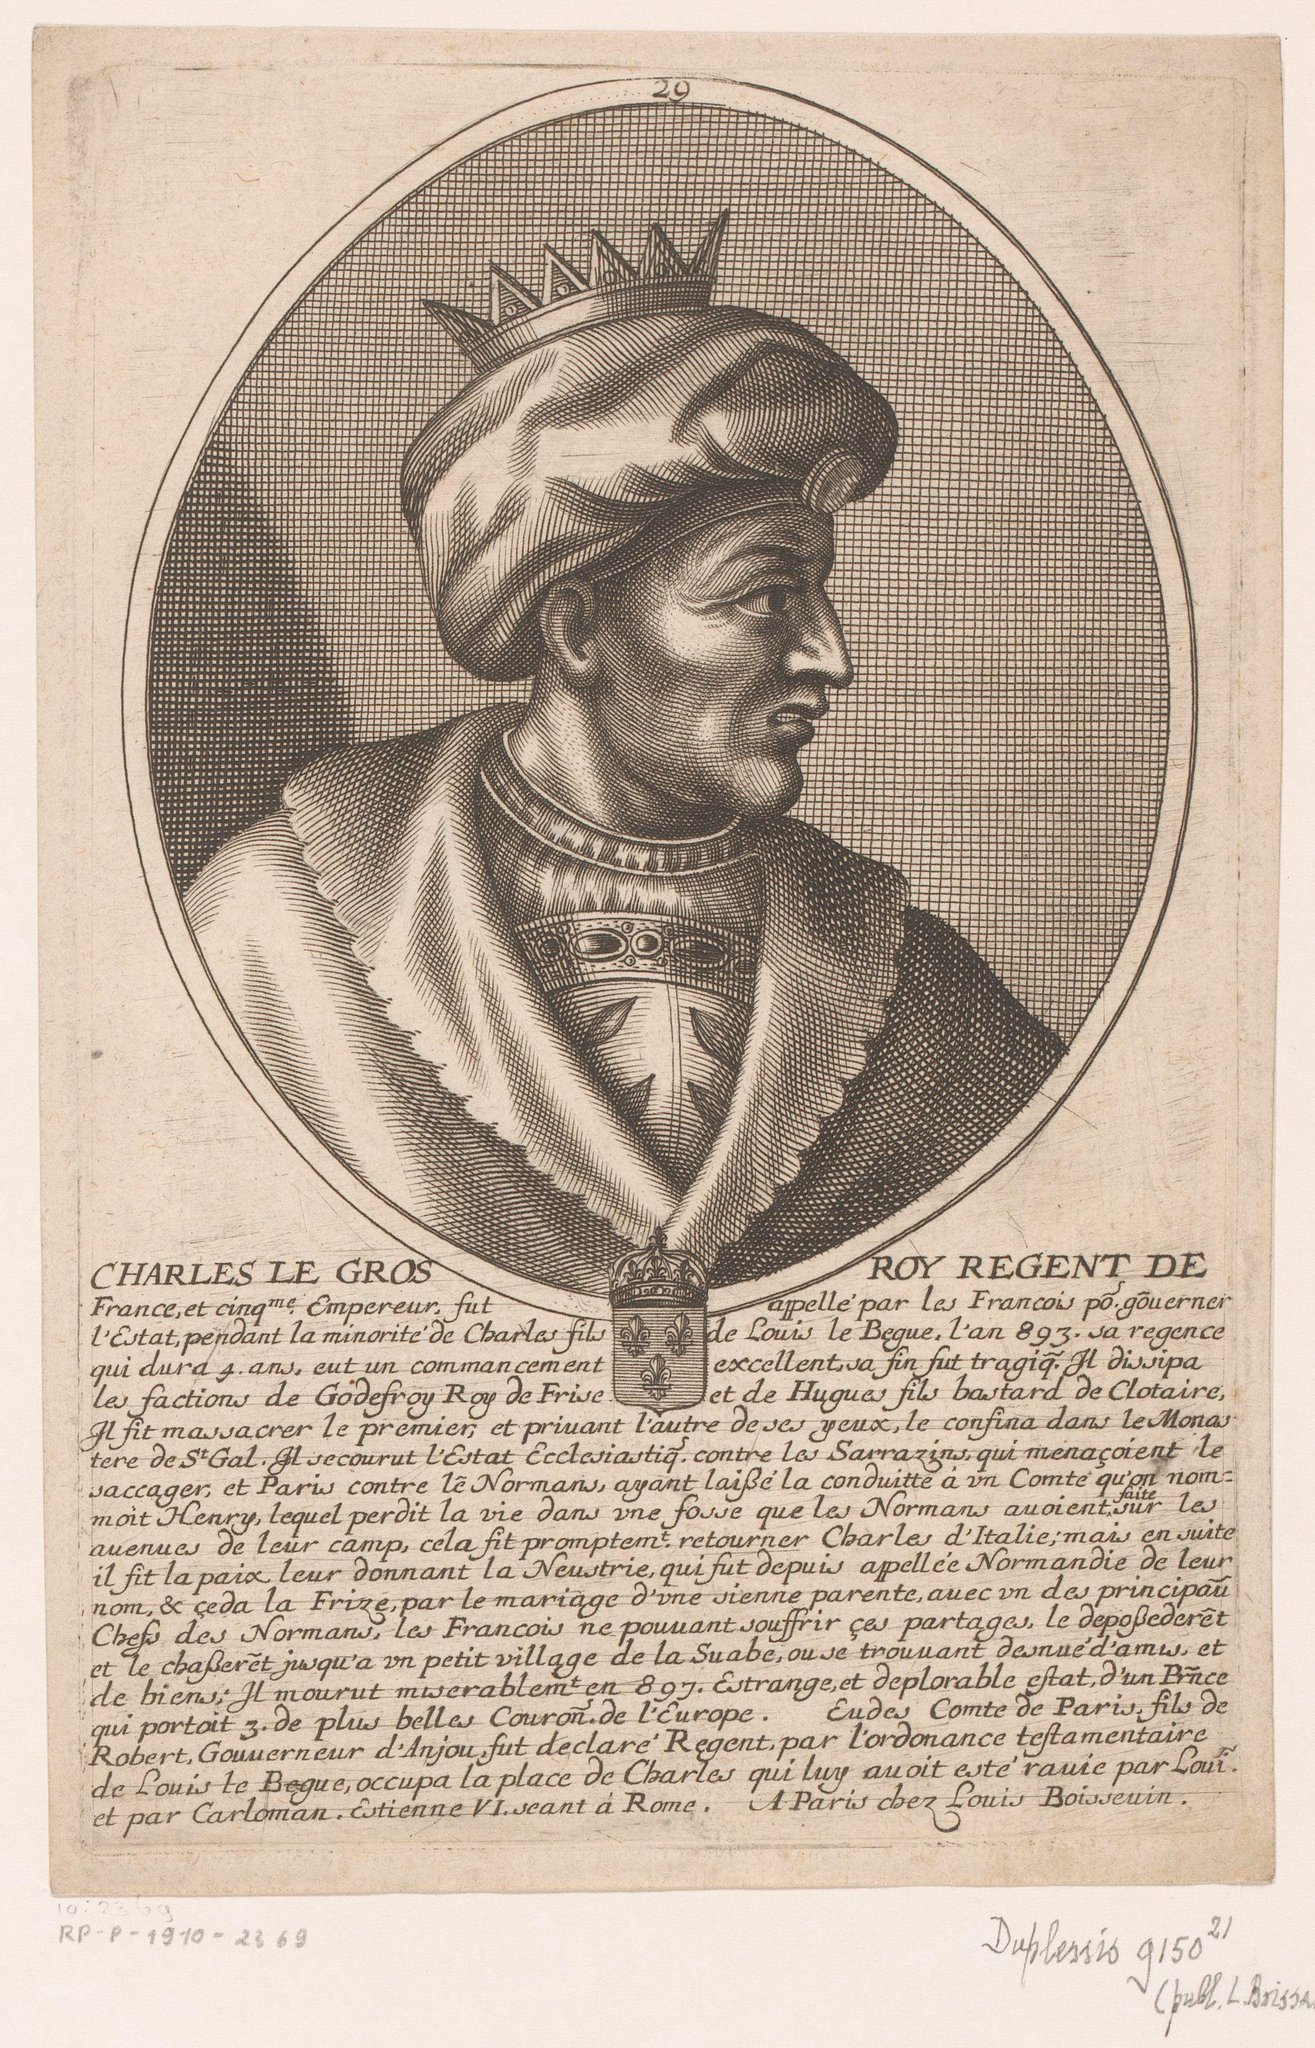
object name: print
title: Portret van Karel III de Dikke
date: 1633-1676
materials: paper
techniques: engraving, etching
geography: france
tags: ornament ~ medallion, armorial bearing, heraldry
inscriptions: collector's mark: Lugt 2228